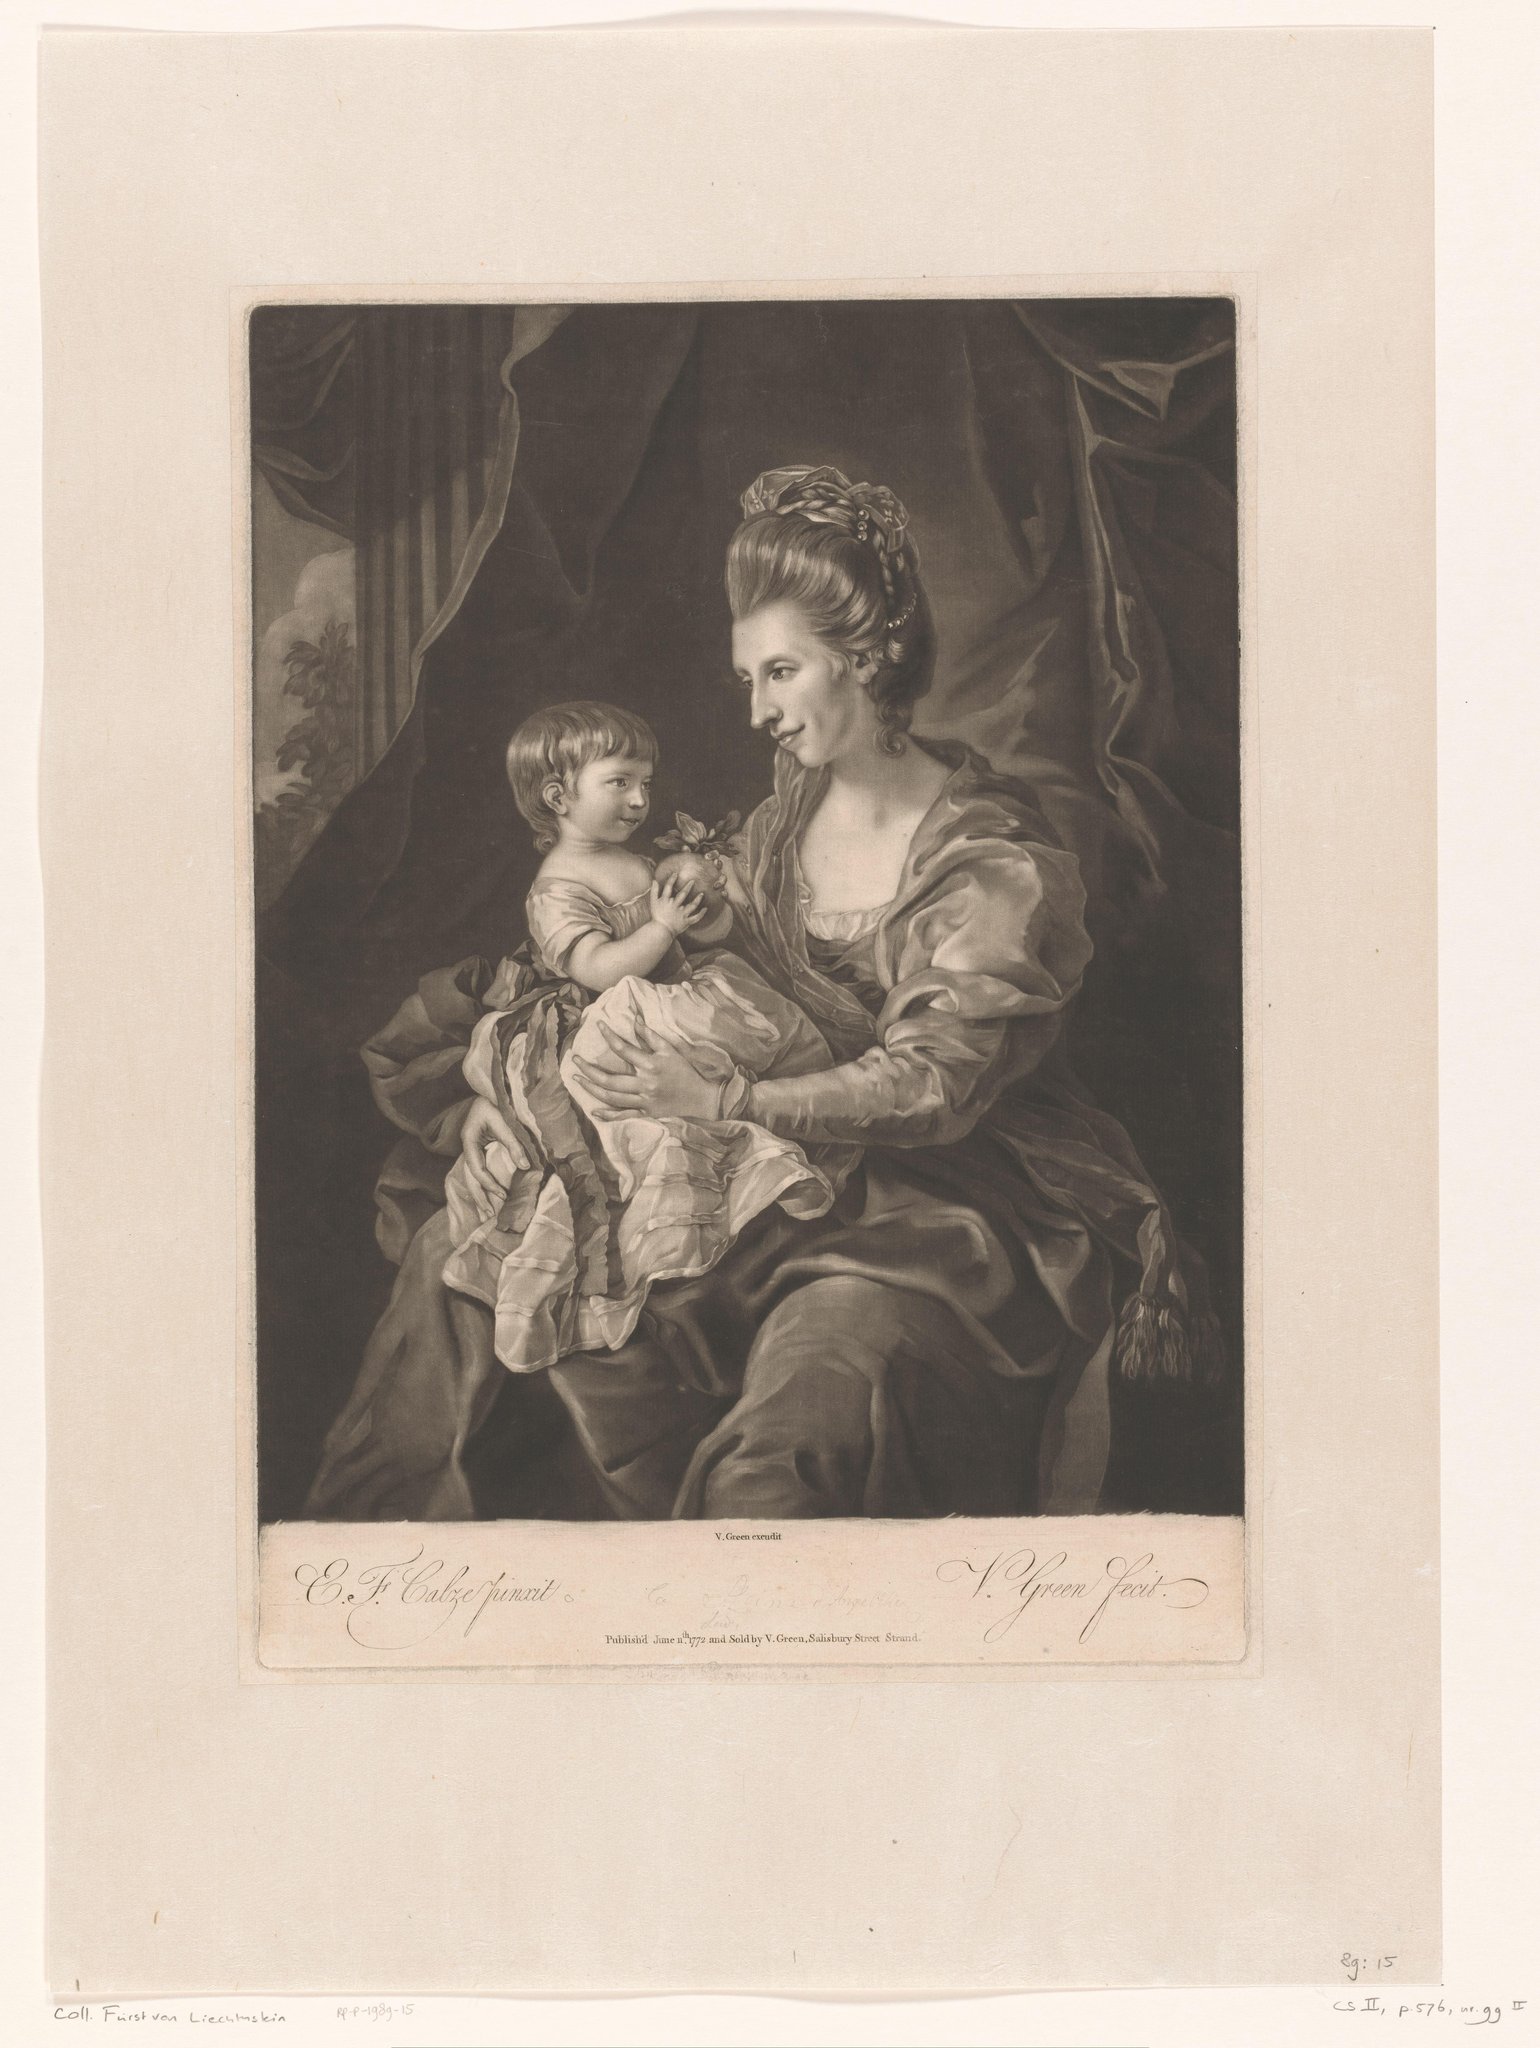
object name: print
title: Portret van Elizabeth Pennyman met haar kind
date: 1706-1772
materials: paper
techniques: mezzotint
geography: london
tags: fruits: apple, historical persons - bb - woman, mother and baby or young child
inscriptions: collector's mark: Lugt 2228, collector's mark: Lugt 2760